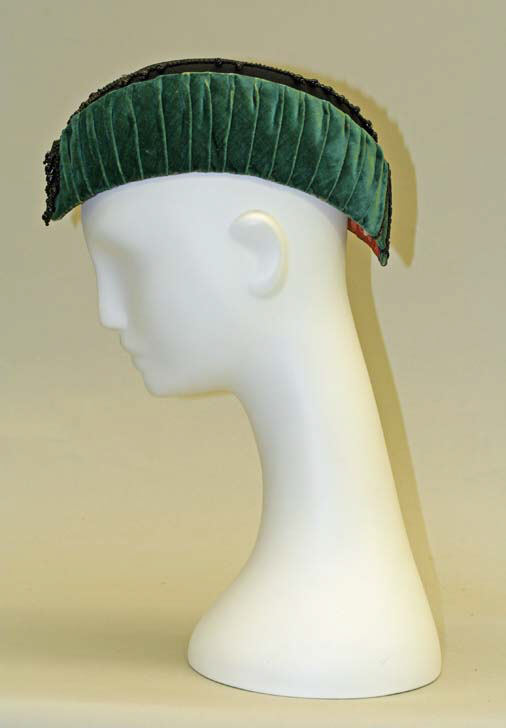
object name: hat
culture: french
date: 1863-1865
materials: silk, wool